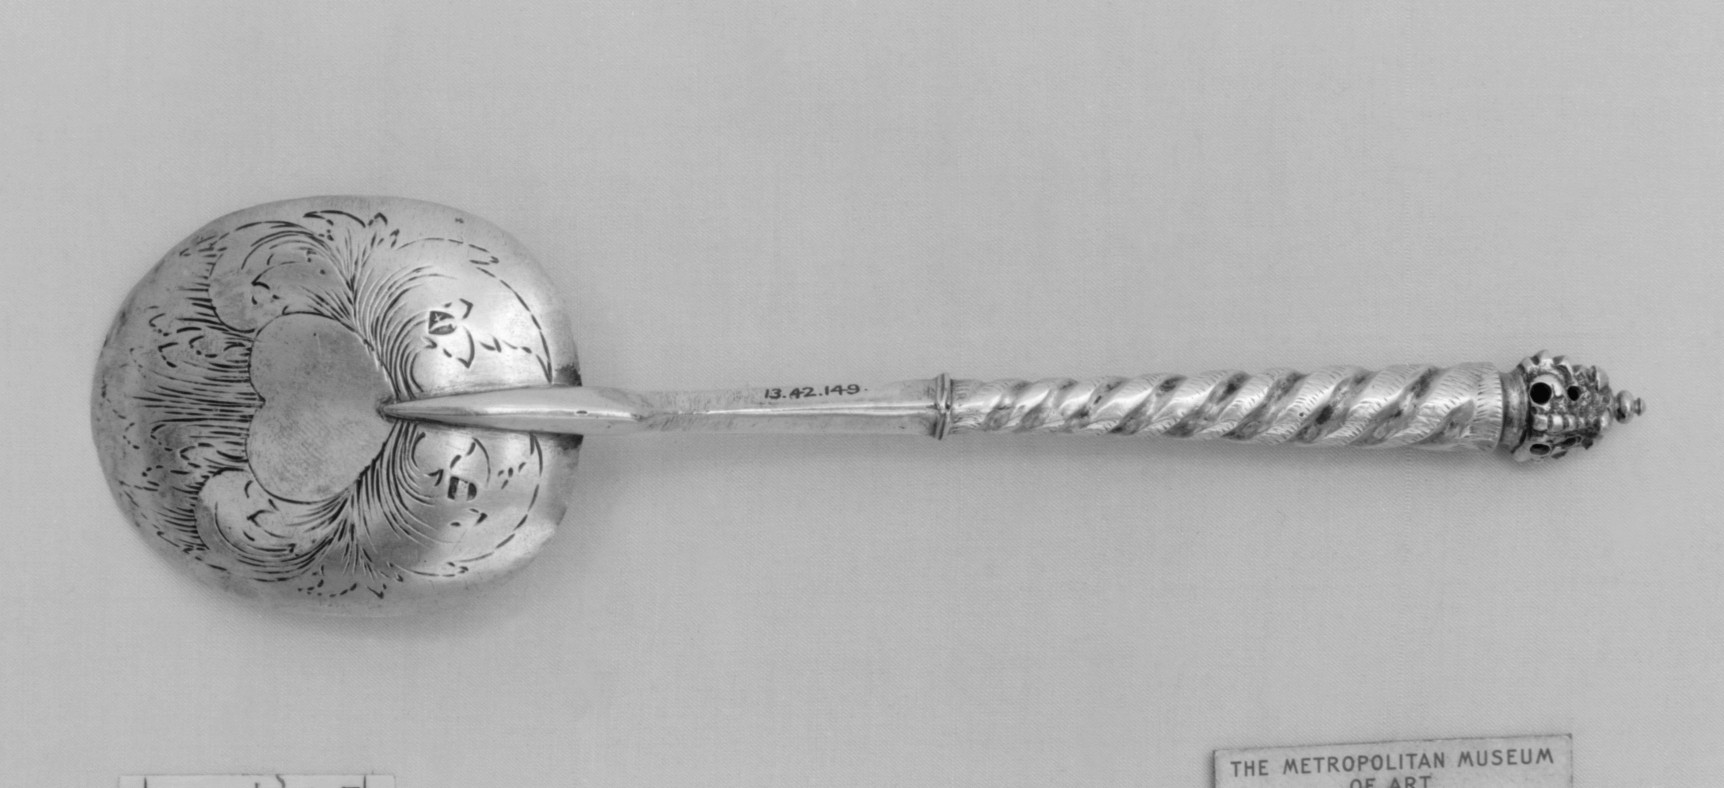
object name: spoon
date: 1601-1700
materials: silver